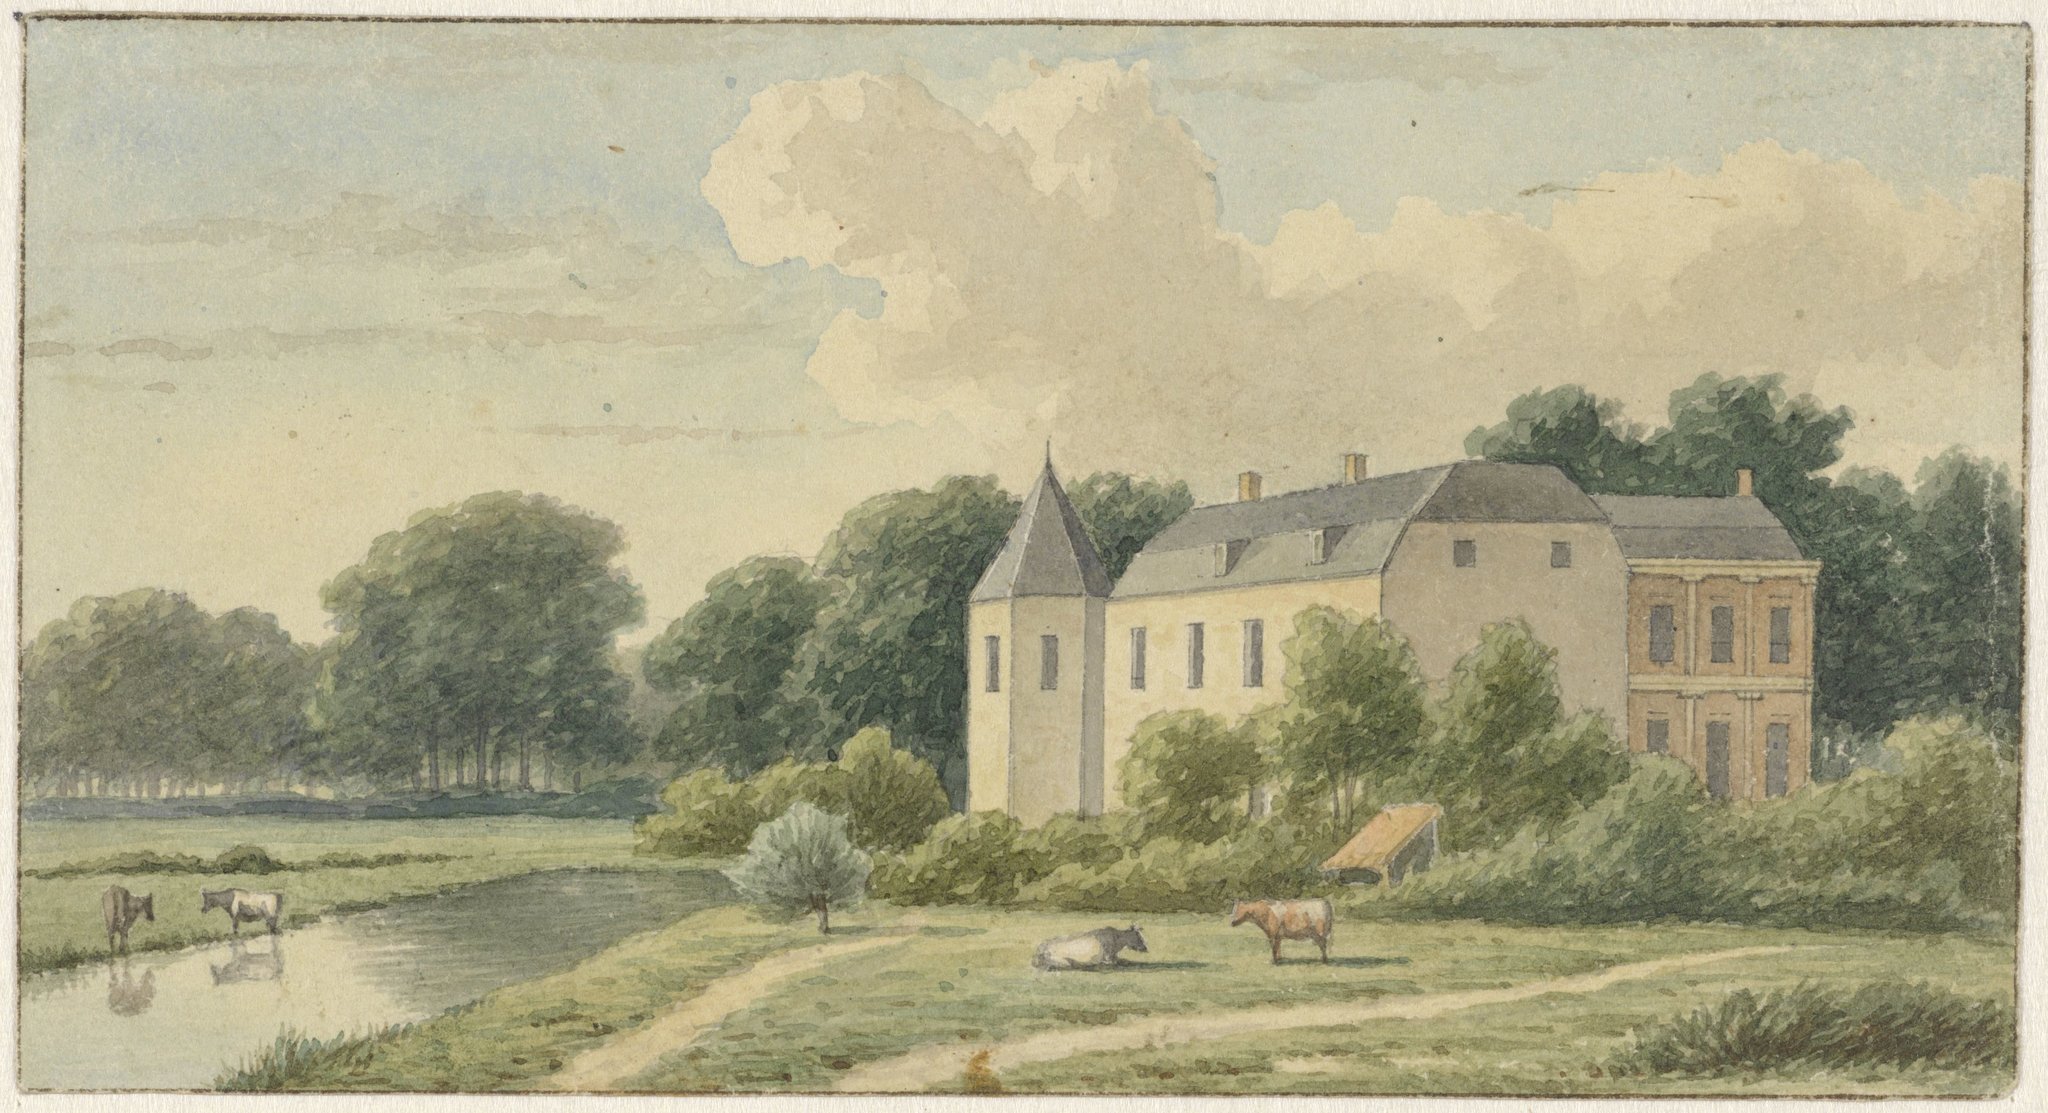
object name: drawing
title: Het Hof te Borculo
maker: christianus hendricus hein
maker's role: draughtsman, print maker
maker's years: 1815-1879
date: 1825-1879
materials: paper, watercolor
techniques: brush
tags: castle